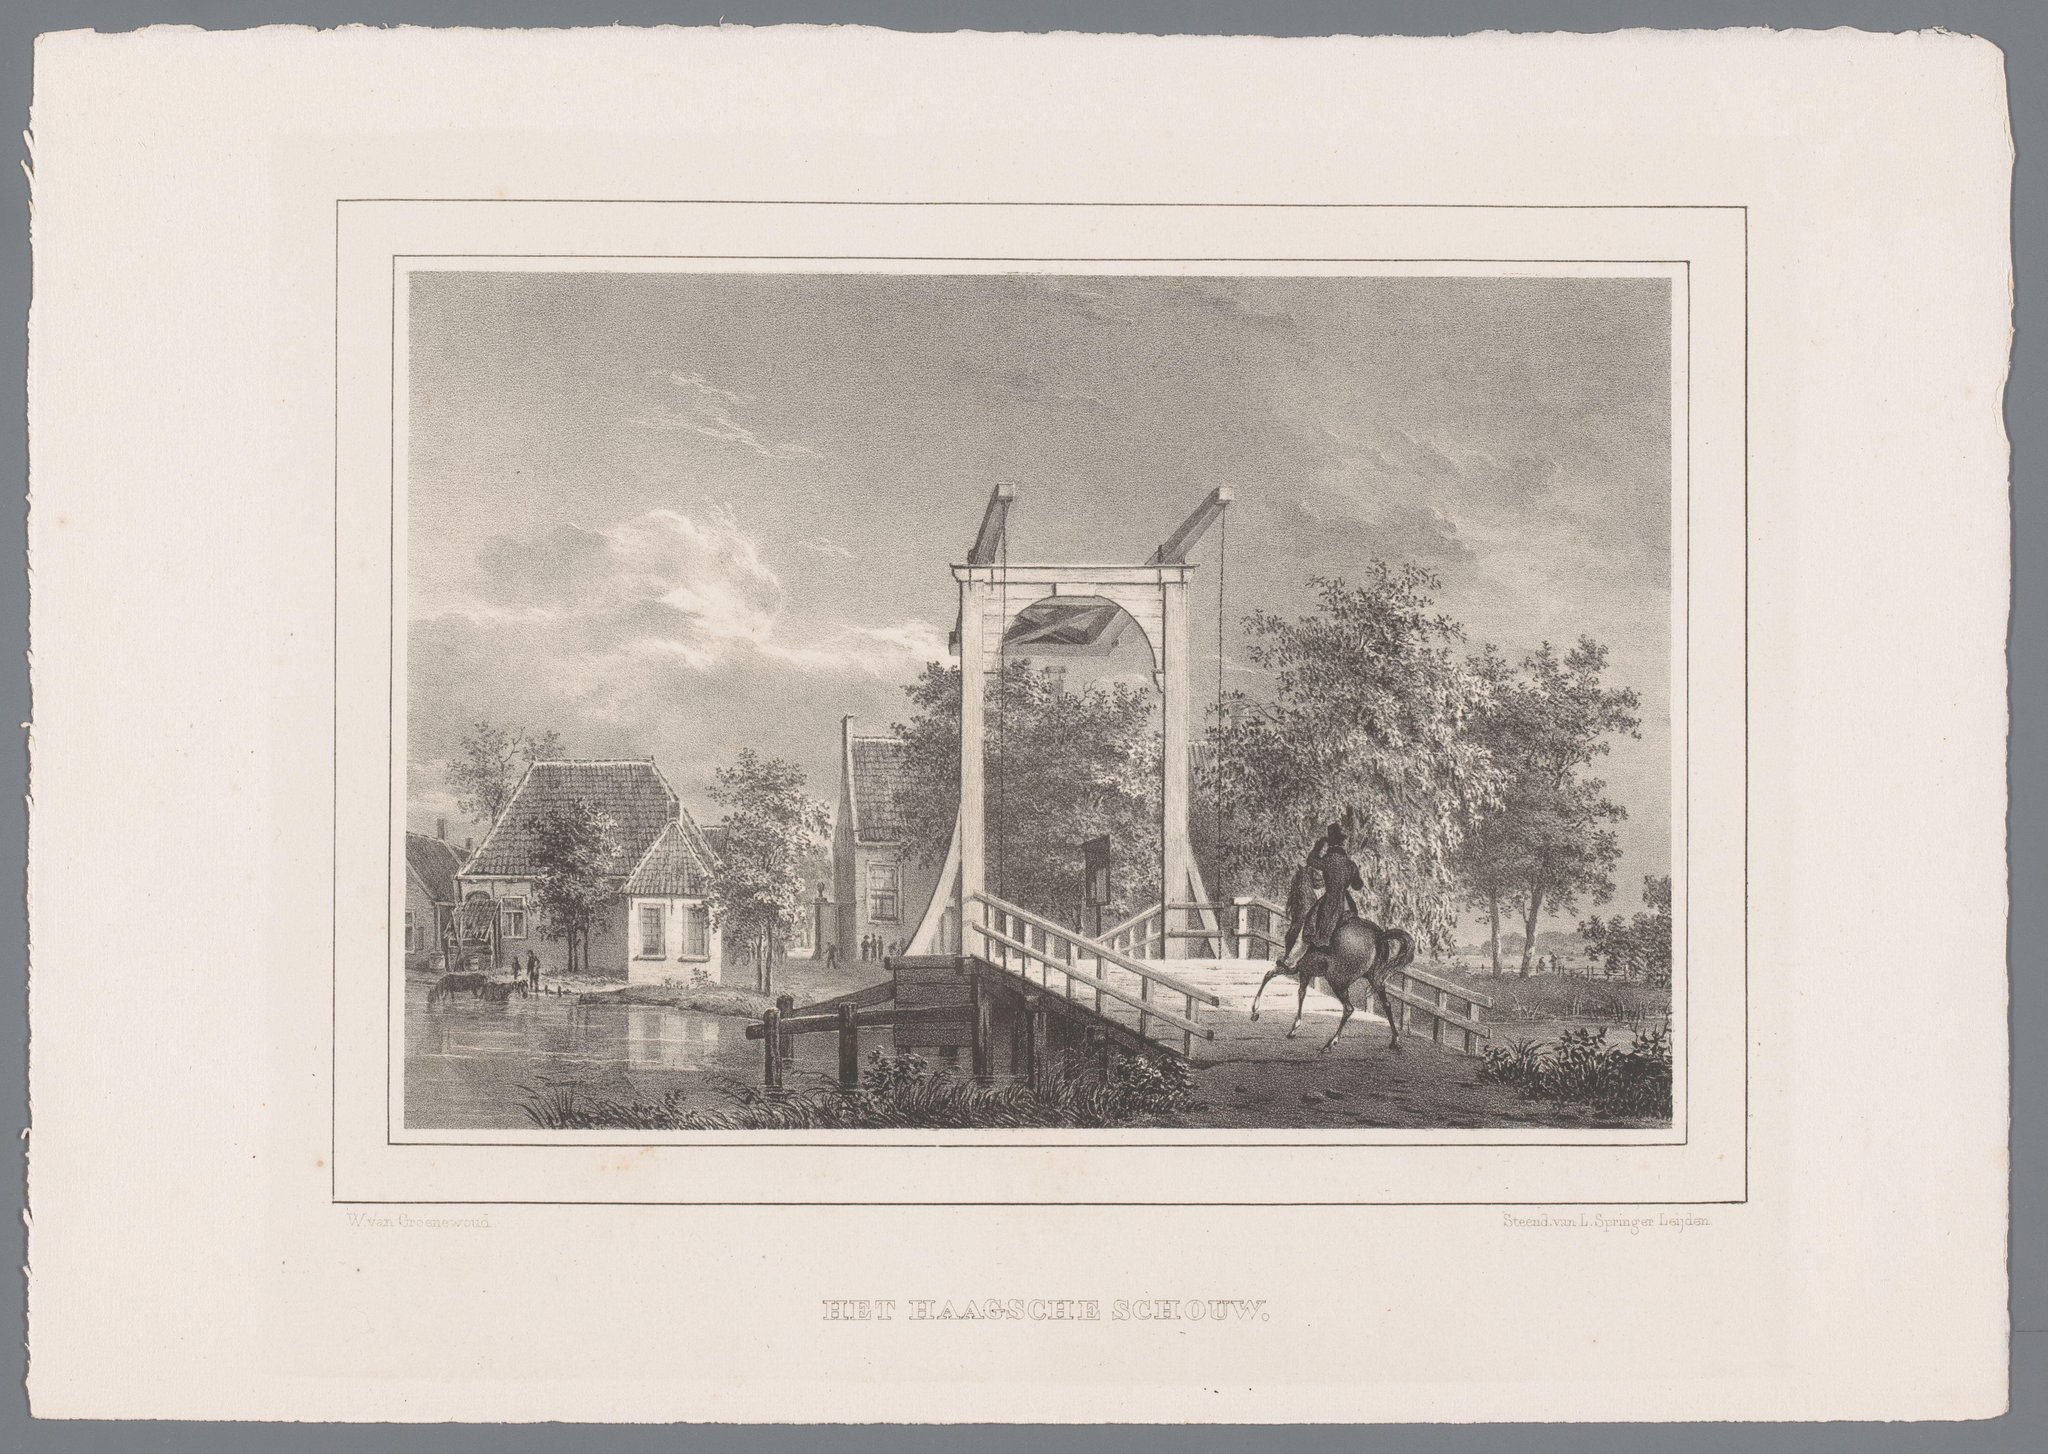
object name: print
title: Gezigten in de omstreeken van Leiden, vervaardigt ter steendrukkerij van L. Springer te Leiden 1843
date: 1834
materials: paper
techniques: lithograph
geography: netherlands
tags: riding a horse, ass, or mule; rider, horseman, bascule bridge, hotel, hostelry, inn, leiden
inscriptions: collector's mark: Lugt 2228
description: Op de ophaalbrug voor de herberg rijdt een ruiter. Deze prent maakt deel uit van een omslag met acht prenten.